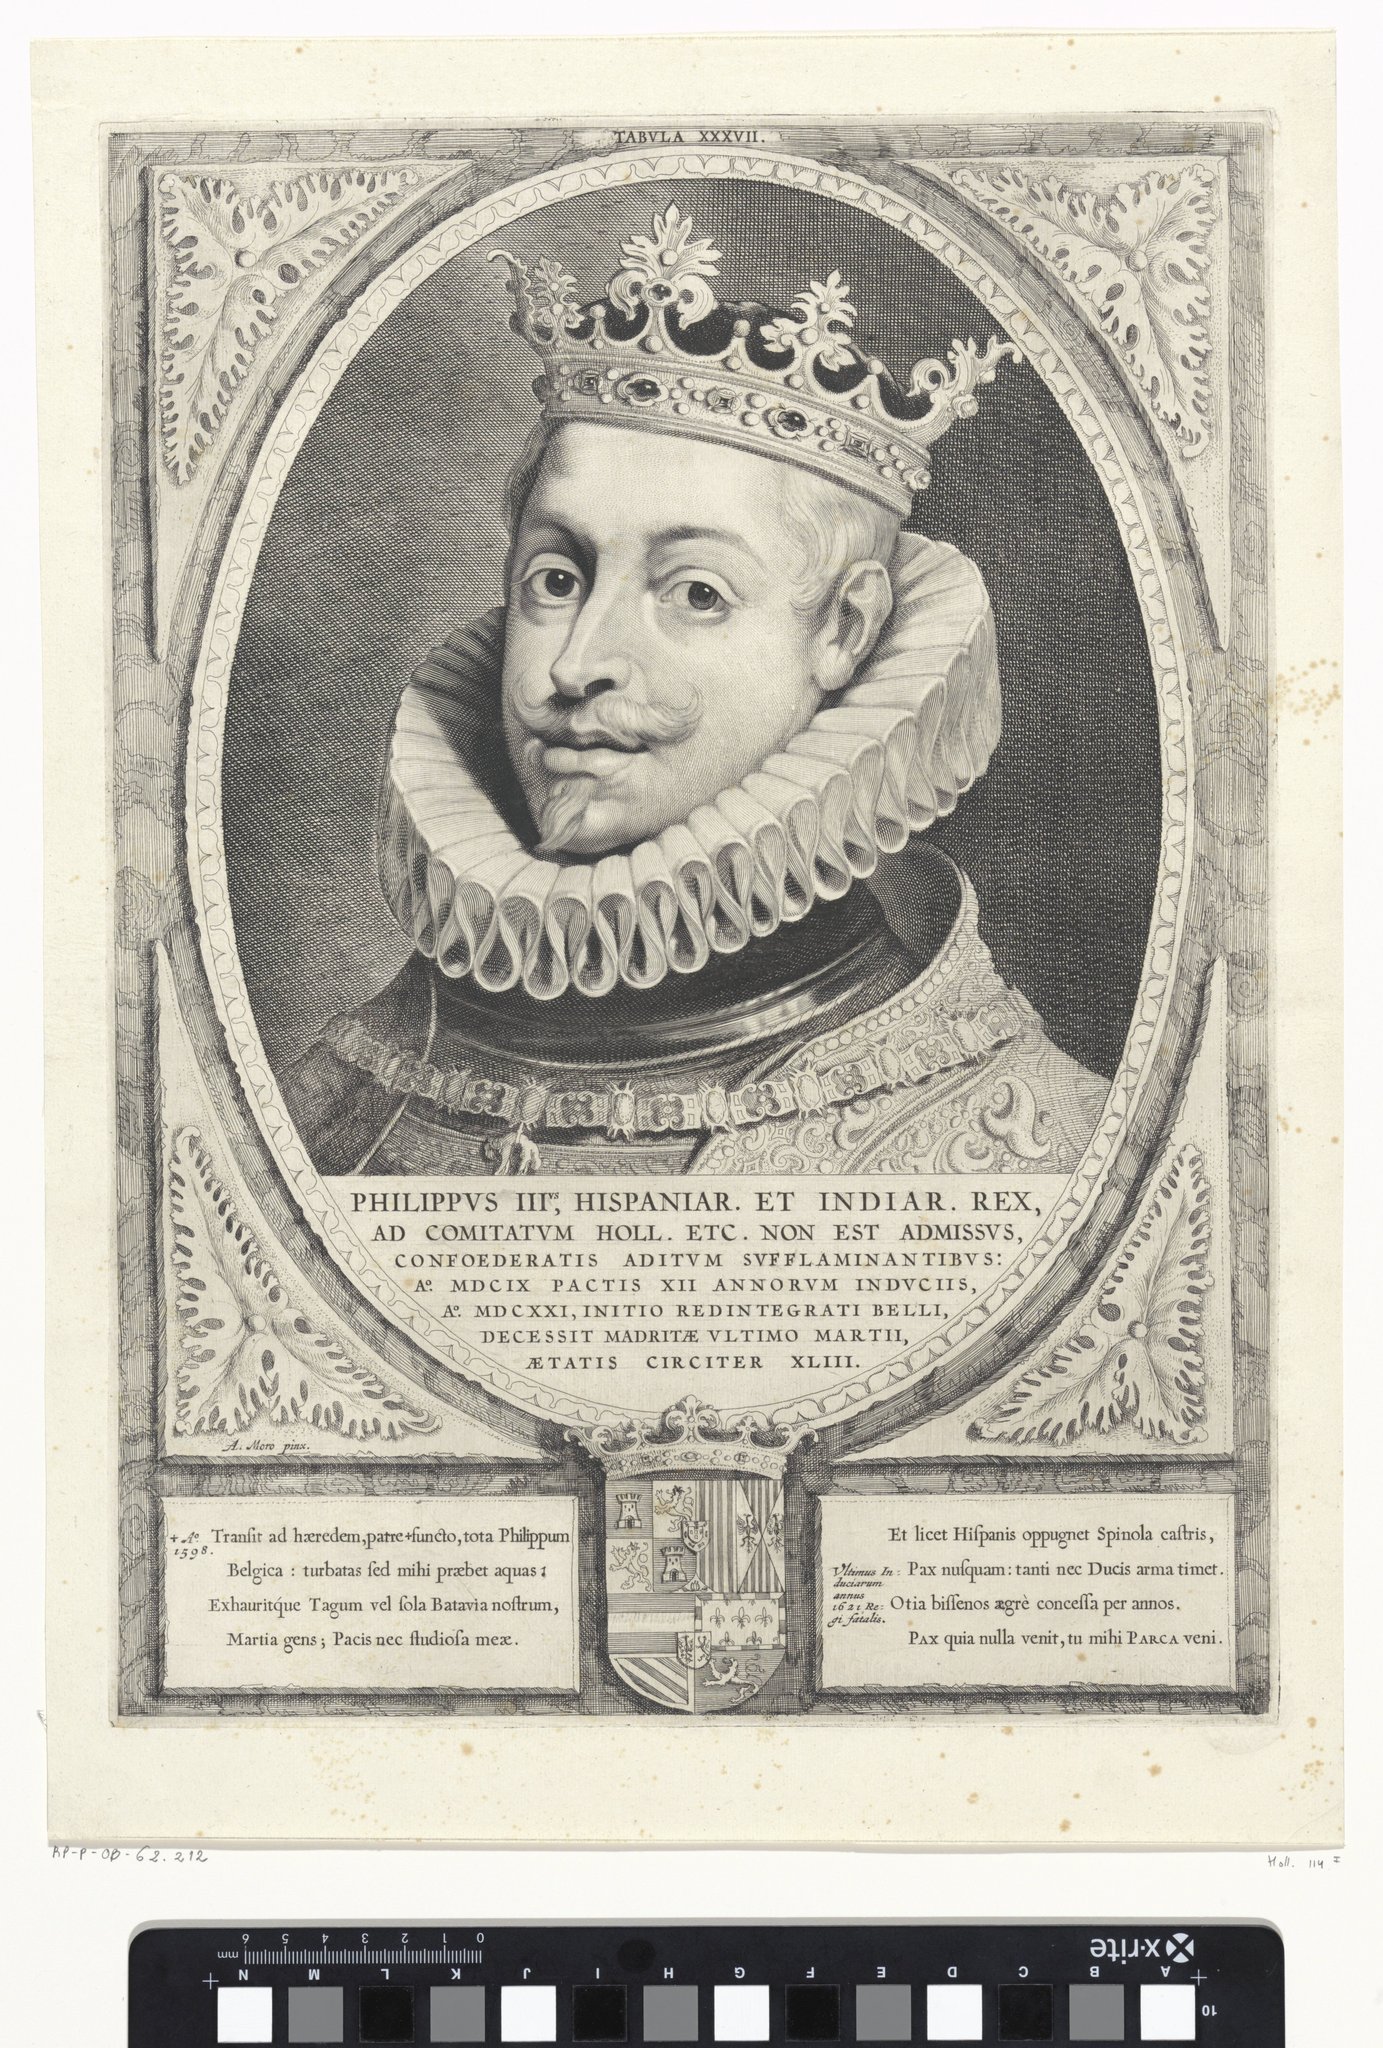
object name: print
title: Portret van Filips III, koning van Spanje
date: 1650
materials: paper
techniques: engraving, etching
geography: haarlem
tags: filips iii (koning van spanje), crown (symbol of sovereignty), armour, knighthood order of the golden fleece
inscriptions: collector's mark: Lugt 12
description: Filips III, koning van Spanje met een brede kraag en een harnas. Op het hoofd een kroon en om zijn hals een keten met het ordeteken van de orde van het gulden vlies.